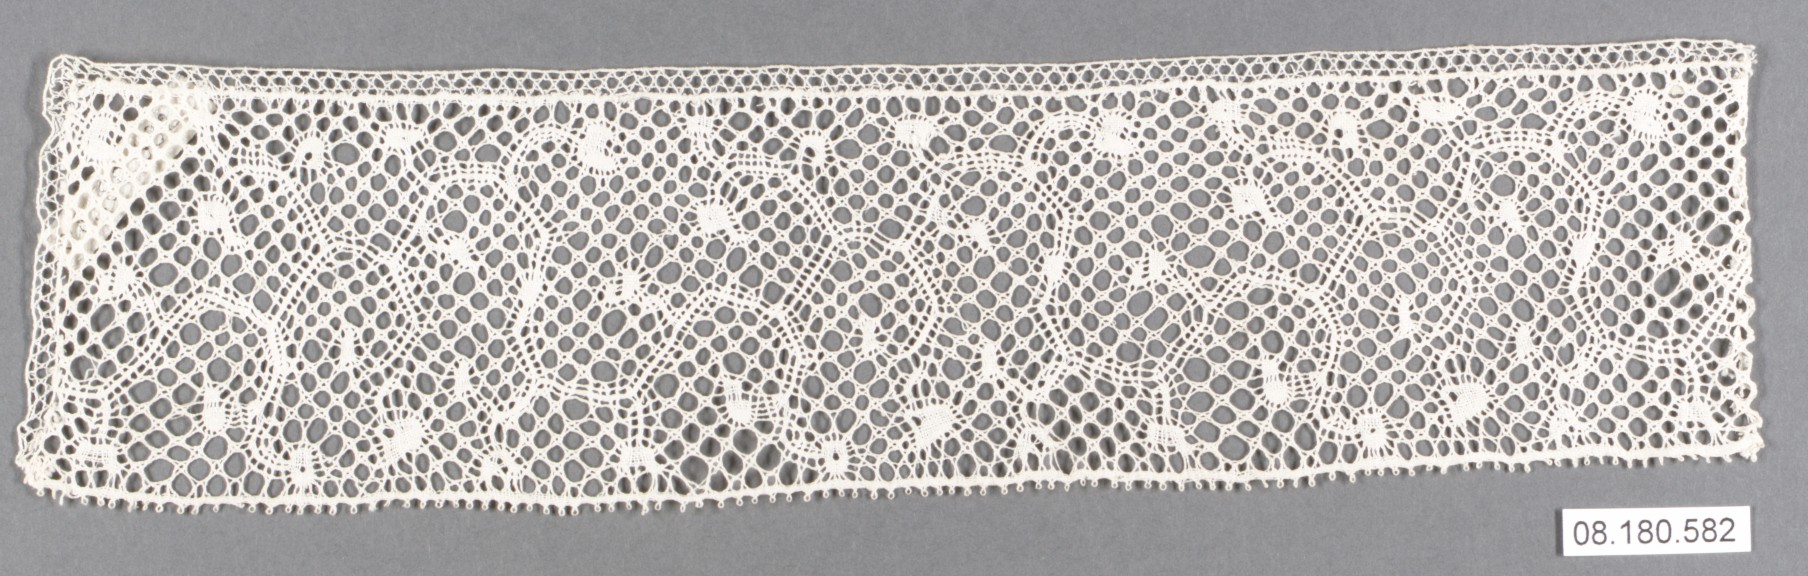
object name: fragment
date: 1801-1900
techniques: lace